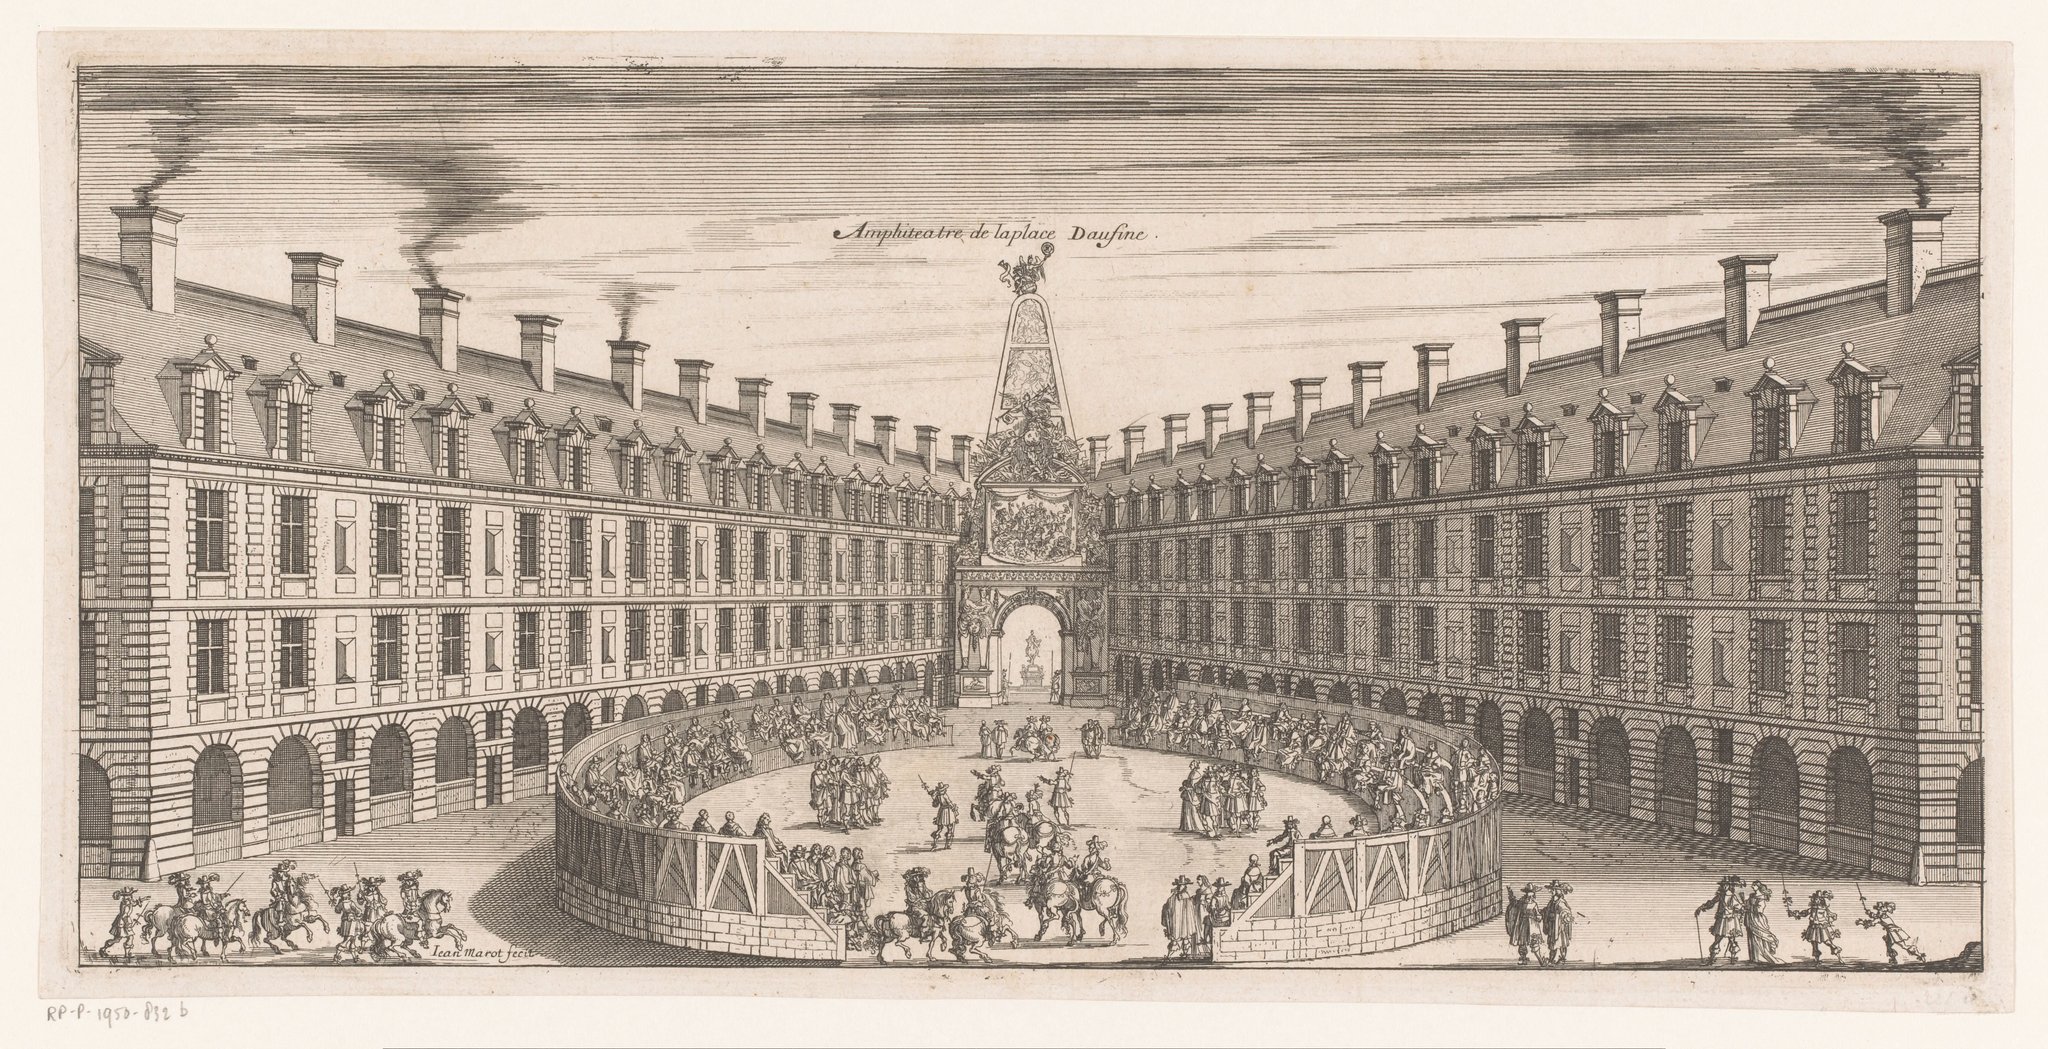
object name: print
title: Gezicht op het amfitheater op het Place Dauphine te Parijs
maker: jean marot (i)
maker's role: print maker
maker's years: 1619-1679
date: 1662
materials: paper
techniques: etching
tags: square, place, circus, etc., city-view in general; 'veduta', amphitheatre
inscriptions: collector's mark: Lugt 2228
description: Prent gebruikt voor: Tronçon, Jean. Entrée triomphante de leurs Majestez Louis XIV roy de France et de Navarre et Marie Therese d'Autriche son epouse dans la ville de Paris (...). Parijs: Pierre Le Petit; Thomas Joly en Louis Bilaine, 1662.